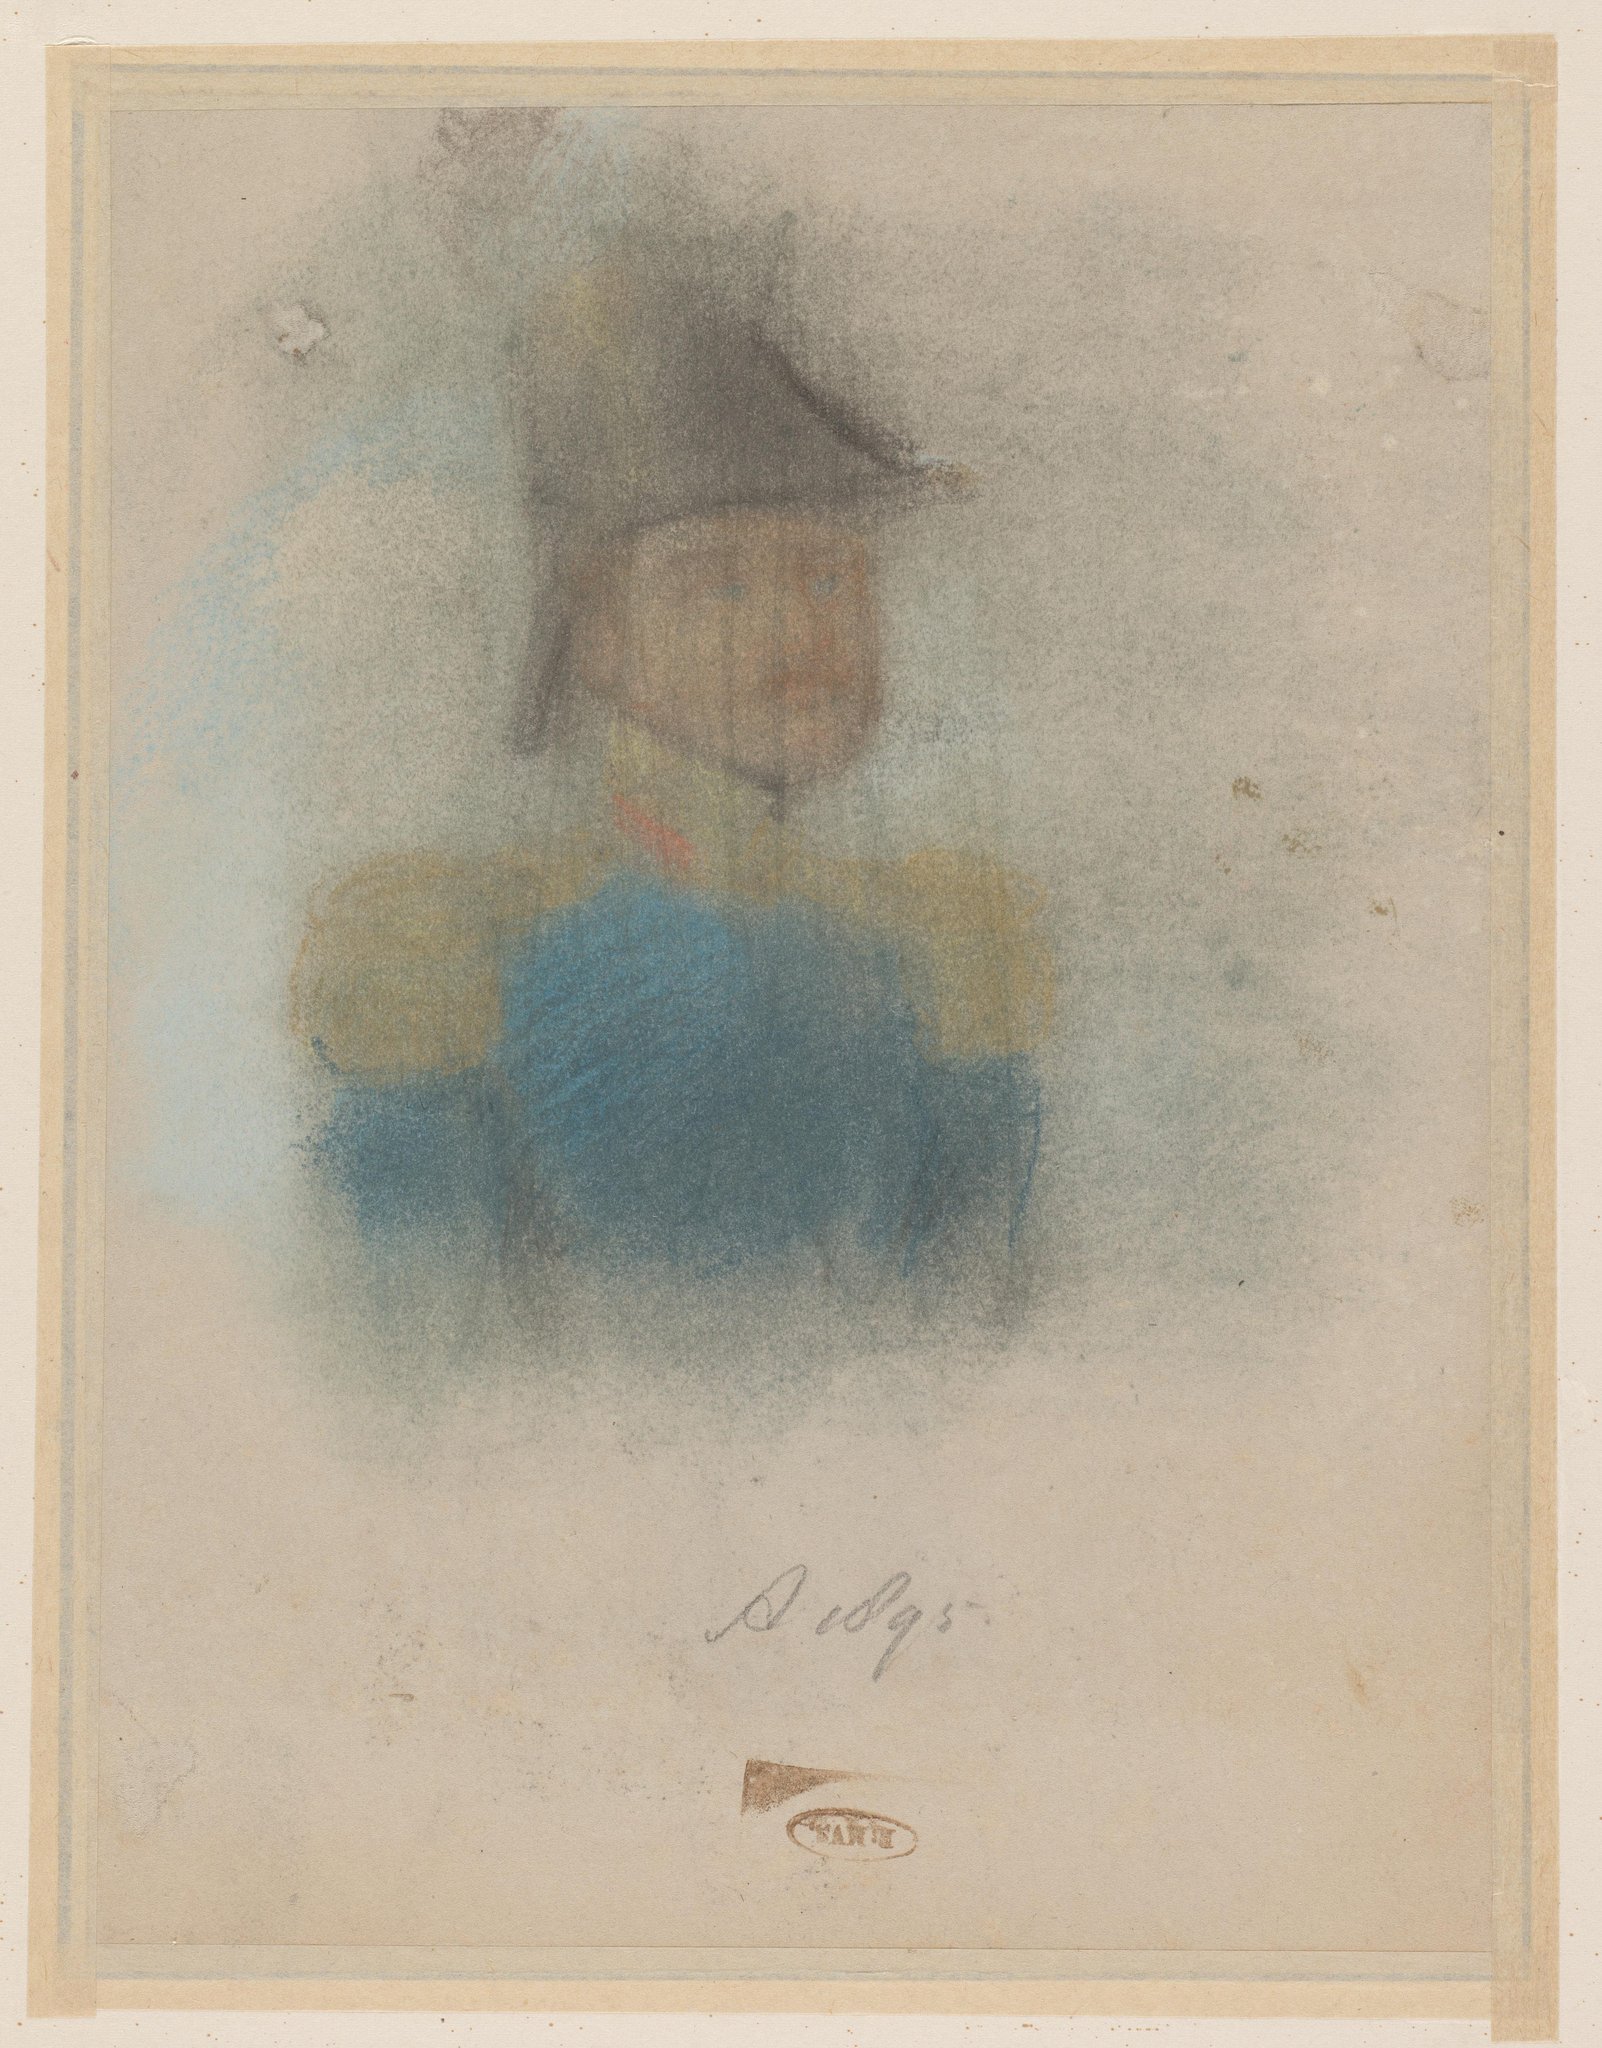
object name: drawing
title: Onvoltooide en afgekeurde schets voor een portret van officier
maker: jacob joseph eeckhout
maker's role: draughtsman, print maker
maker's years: 1793-1861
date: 1803-1861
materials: paper, pastel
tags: anonymous historical person portrayed alone, officer